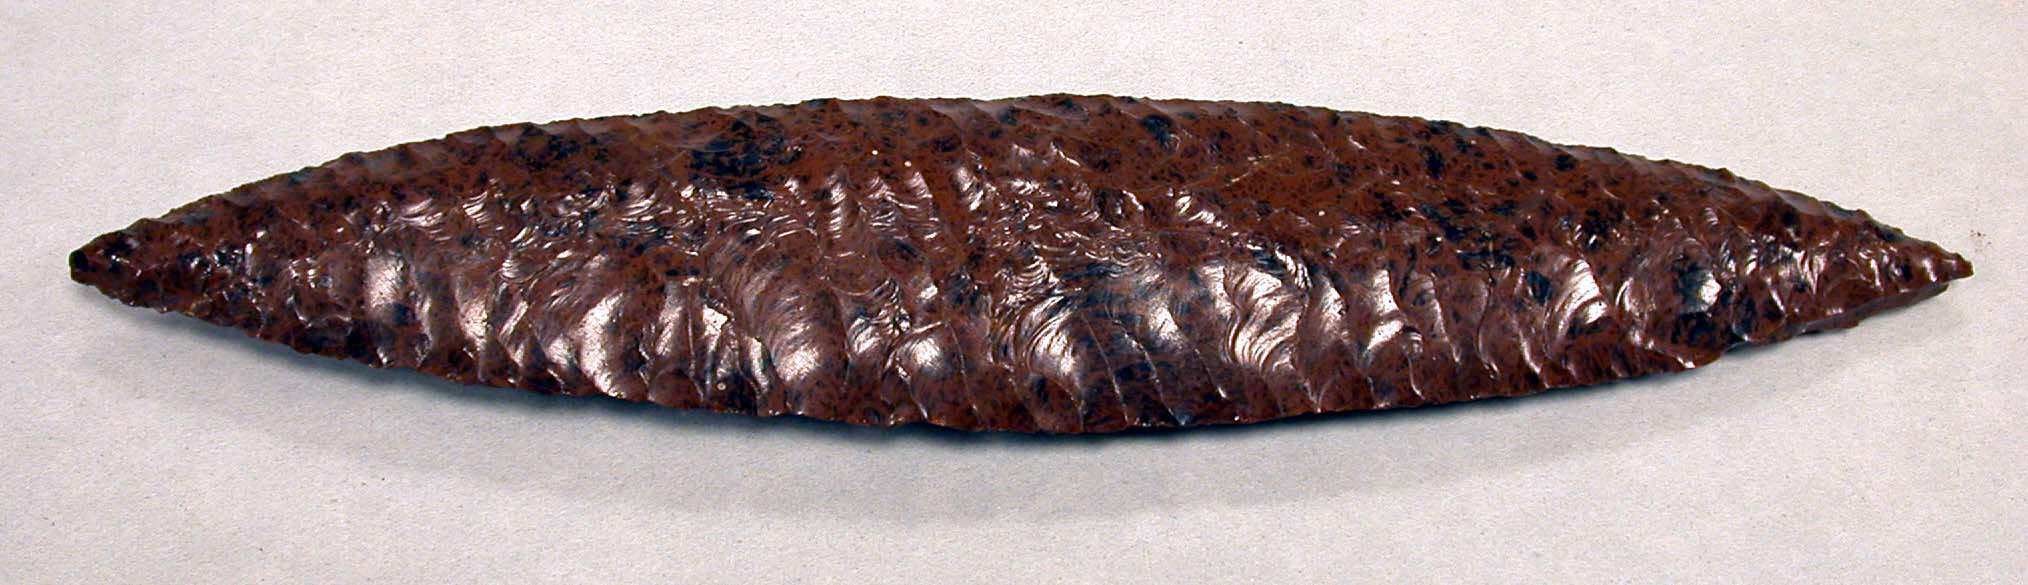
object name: knife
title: Obsidian Blade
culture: mexican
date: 1501-1600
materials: obsidian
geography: mexico